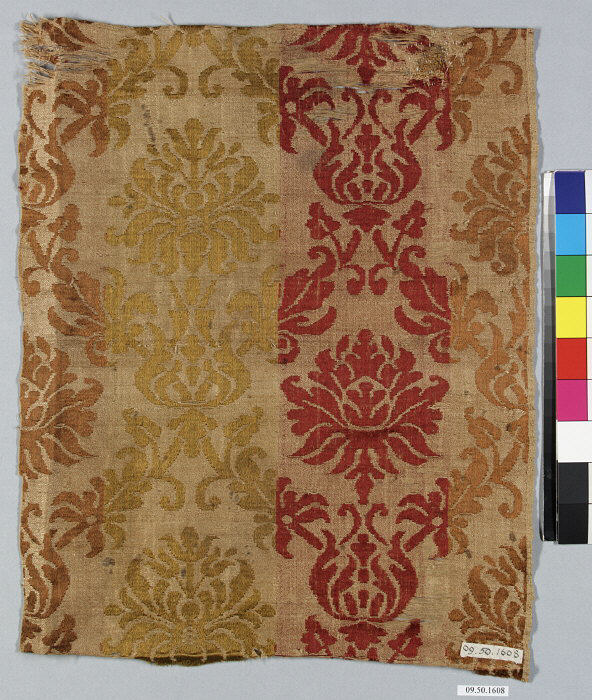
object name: piece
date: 1801-1900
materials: cotton, silk